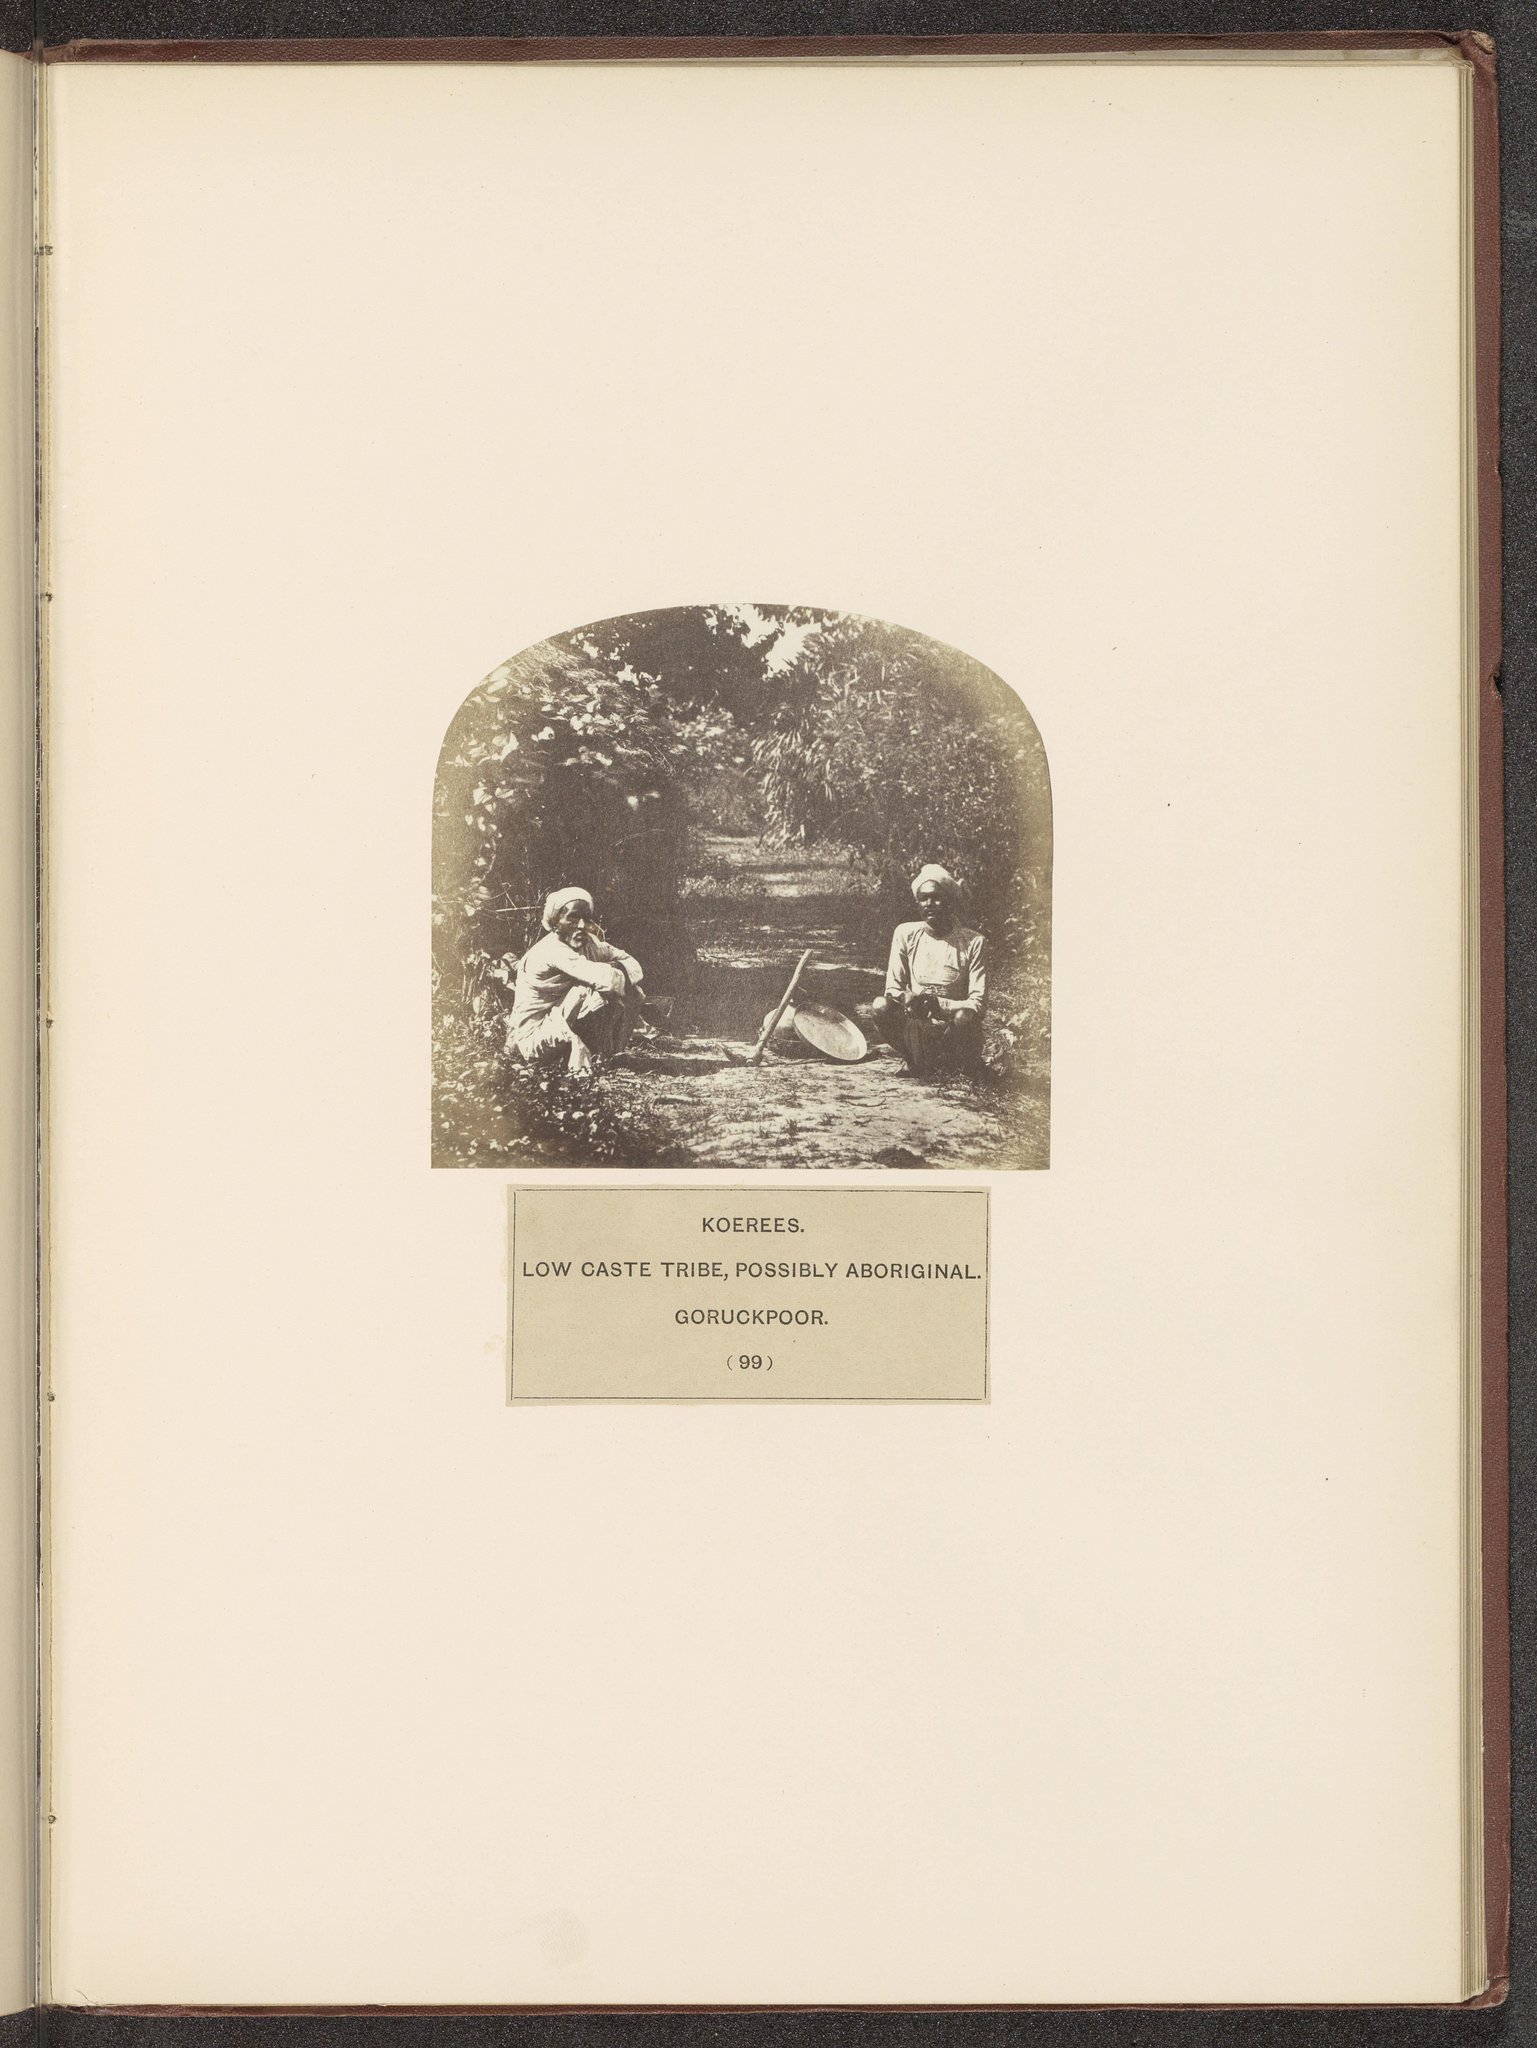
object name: page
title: Two unknown men on a path with agricultural tools from the Kori community of Gorakhpur, Uttar Pradesh, India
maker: Anonymous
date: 1858-1868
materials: photographic support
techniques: albumen print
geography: gorakhpur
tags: road, path, agricultural implements, human races; peoples; nationalities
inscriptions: inscription: ‘KOEREES./ LOW CASTE TRIBE, POSSIBLY ABORIGINAL./ GORUCKPOOR.’, number: ‘(99)’